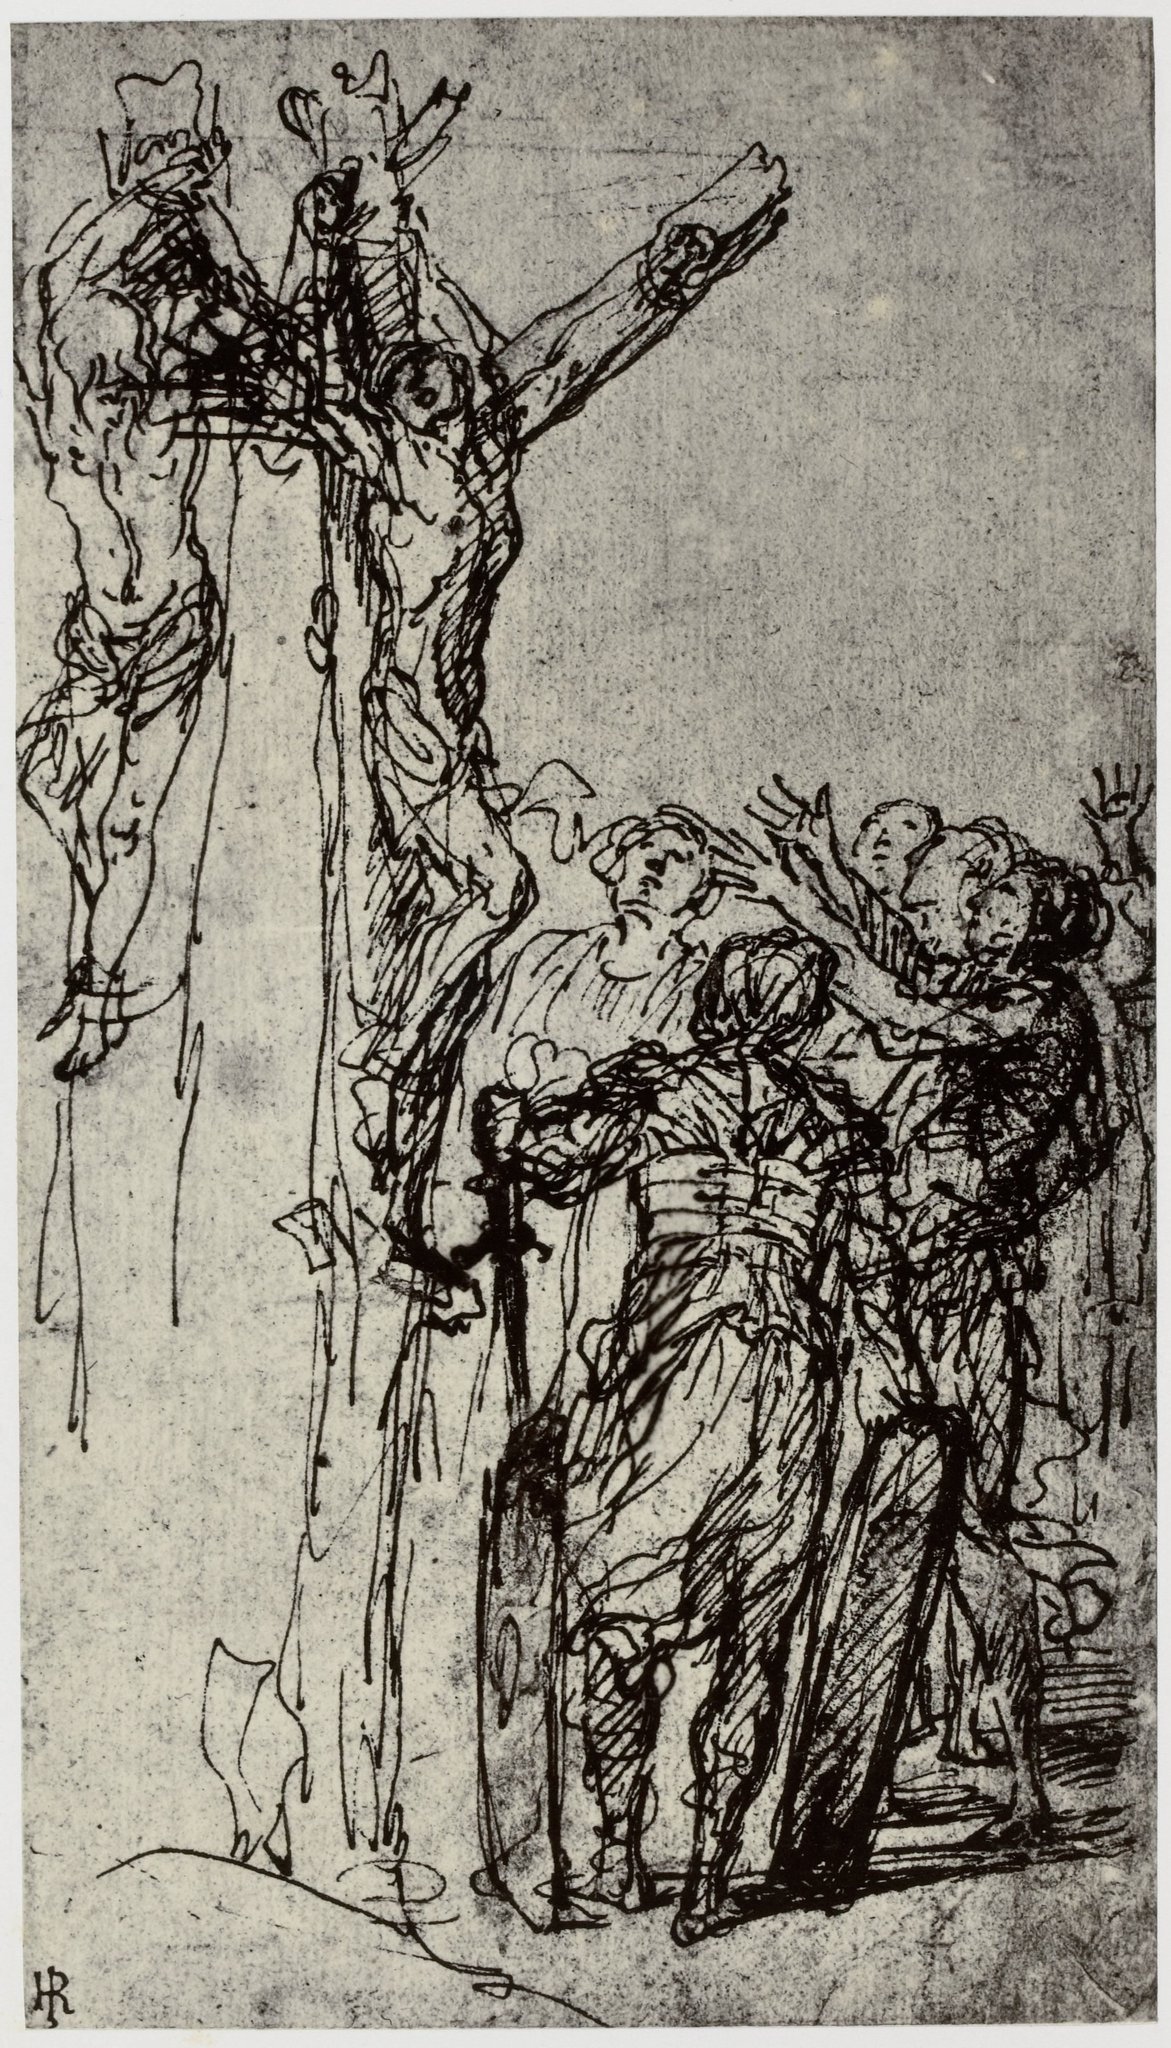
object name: photograph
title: Salvator Rosa, The Death of Polycrates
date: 1855-1858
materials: cardboard, paper, photographic support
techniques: albumen print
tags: naples, print maker, salvator rosa, drawing, sketch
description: Fotoreproductie van tekening in 'The Reveley Collection of Drawings at Brynygwin', afb. 35.